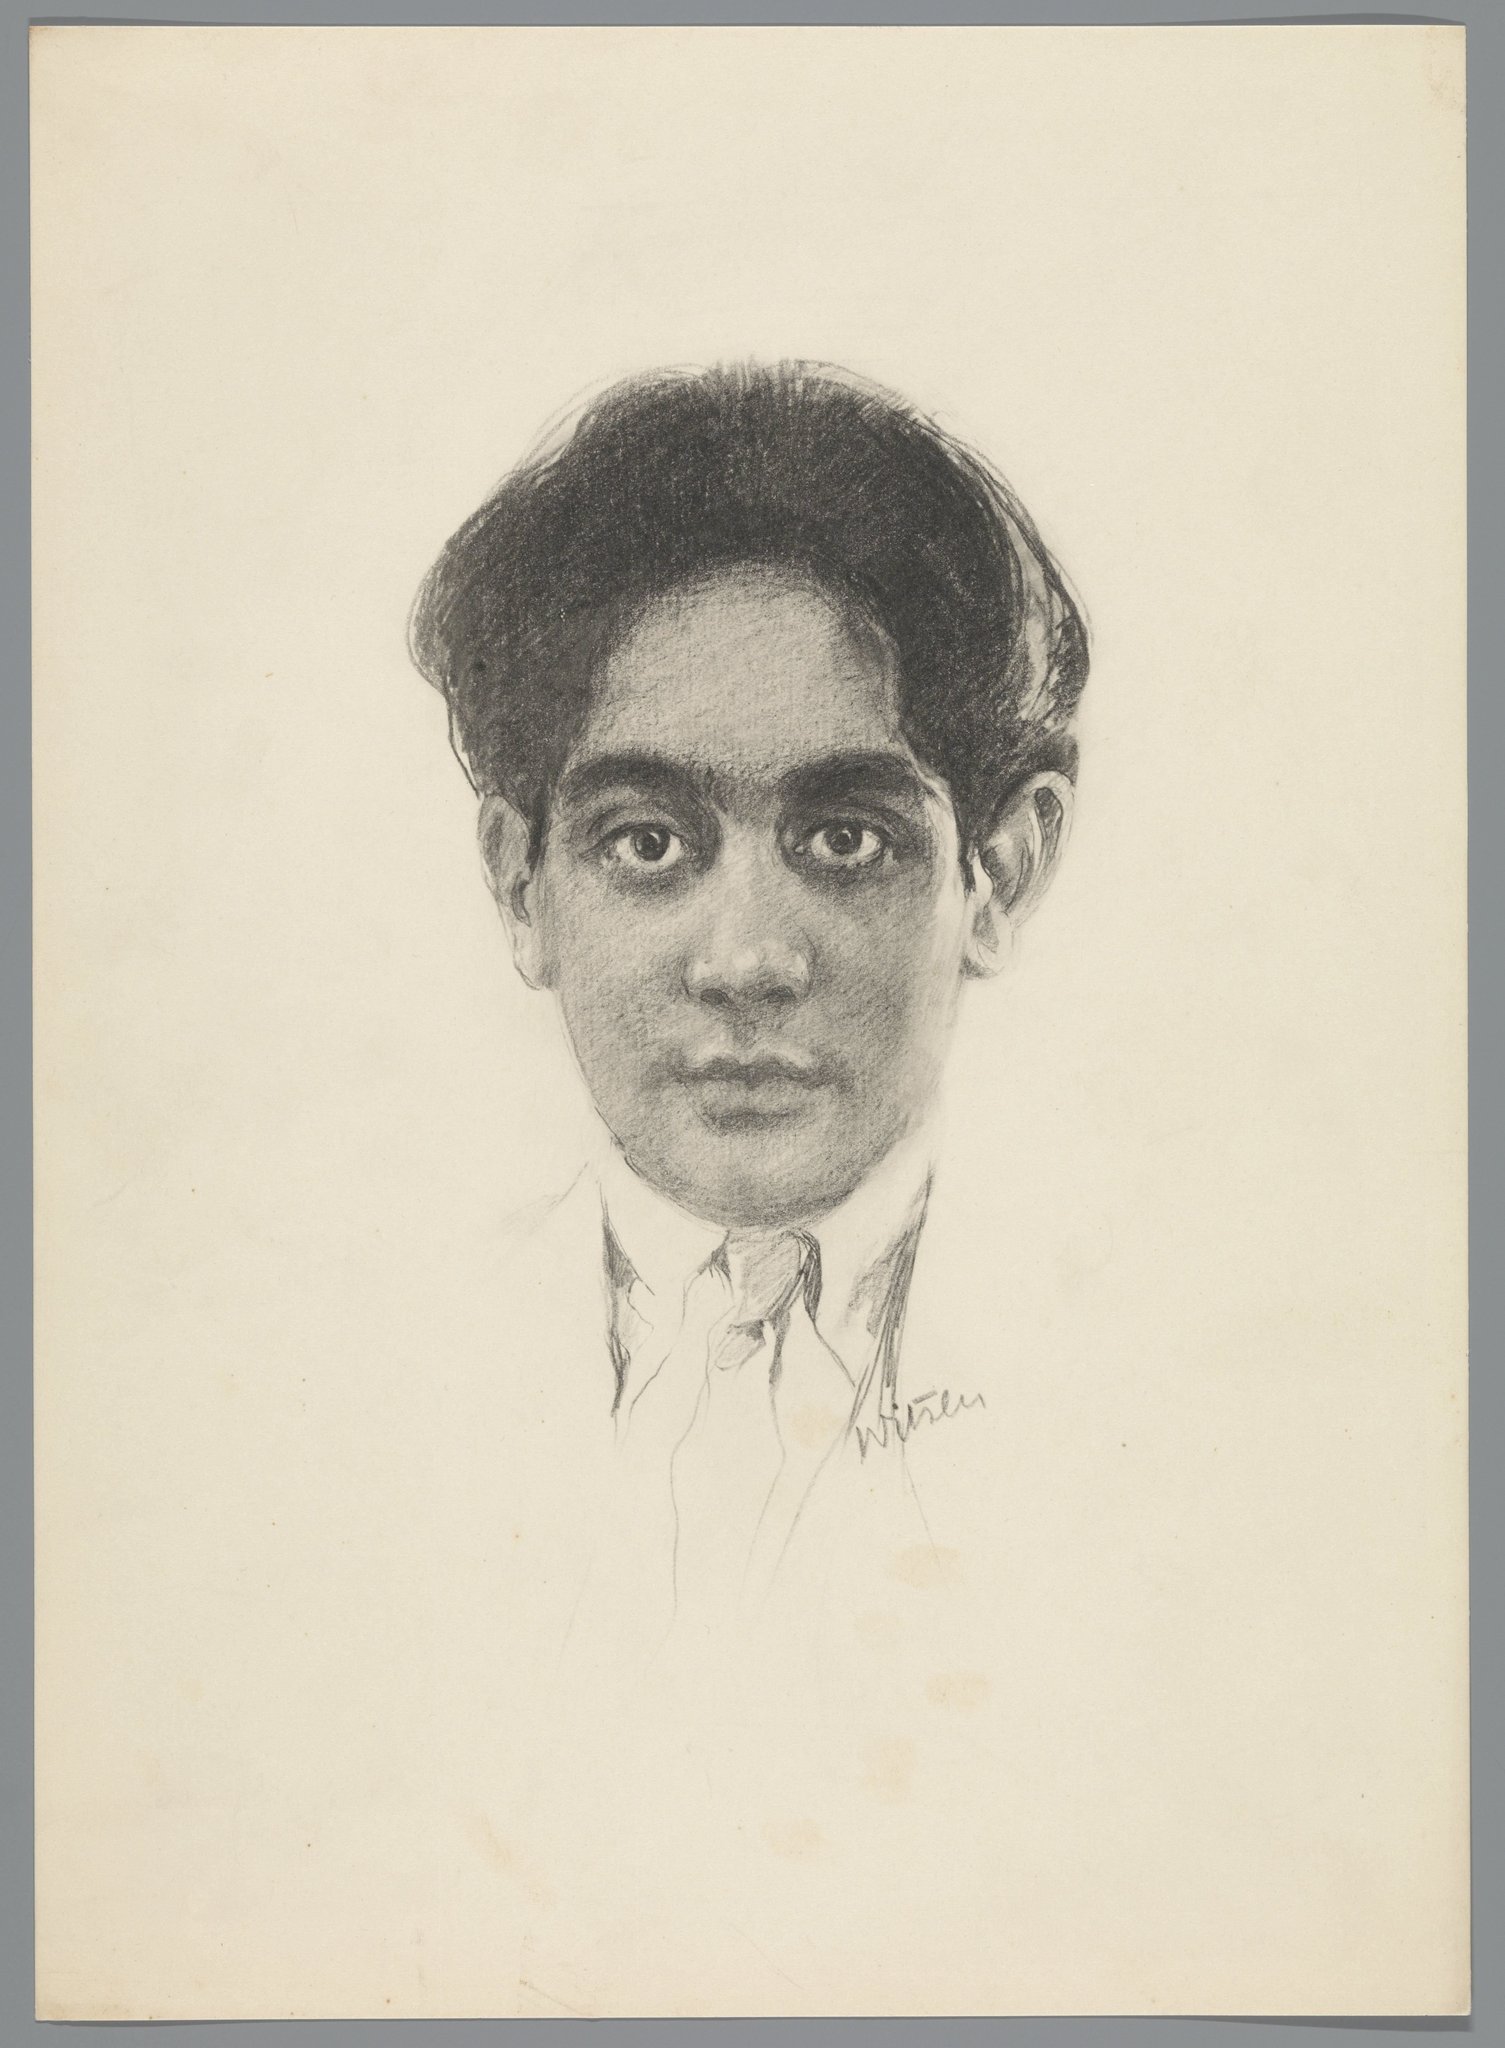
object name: reproduction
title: Reproductie van tekening met portret van Karamjit Singh Sahib Bahadur, prins van Kapurthala, door Willem Witsen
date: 1915-1916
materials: paper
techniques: photograph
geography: netherlands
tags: politician, historical persons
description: Voor schilderij van de geportretteerde door Witsen, zie collectie Dordrechts Museum (bruikleen RCE).